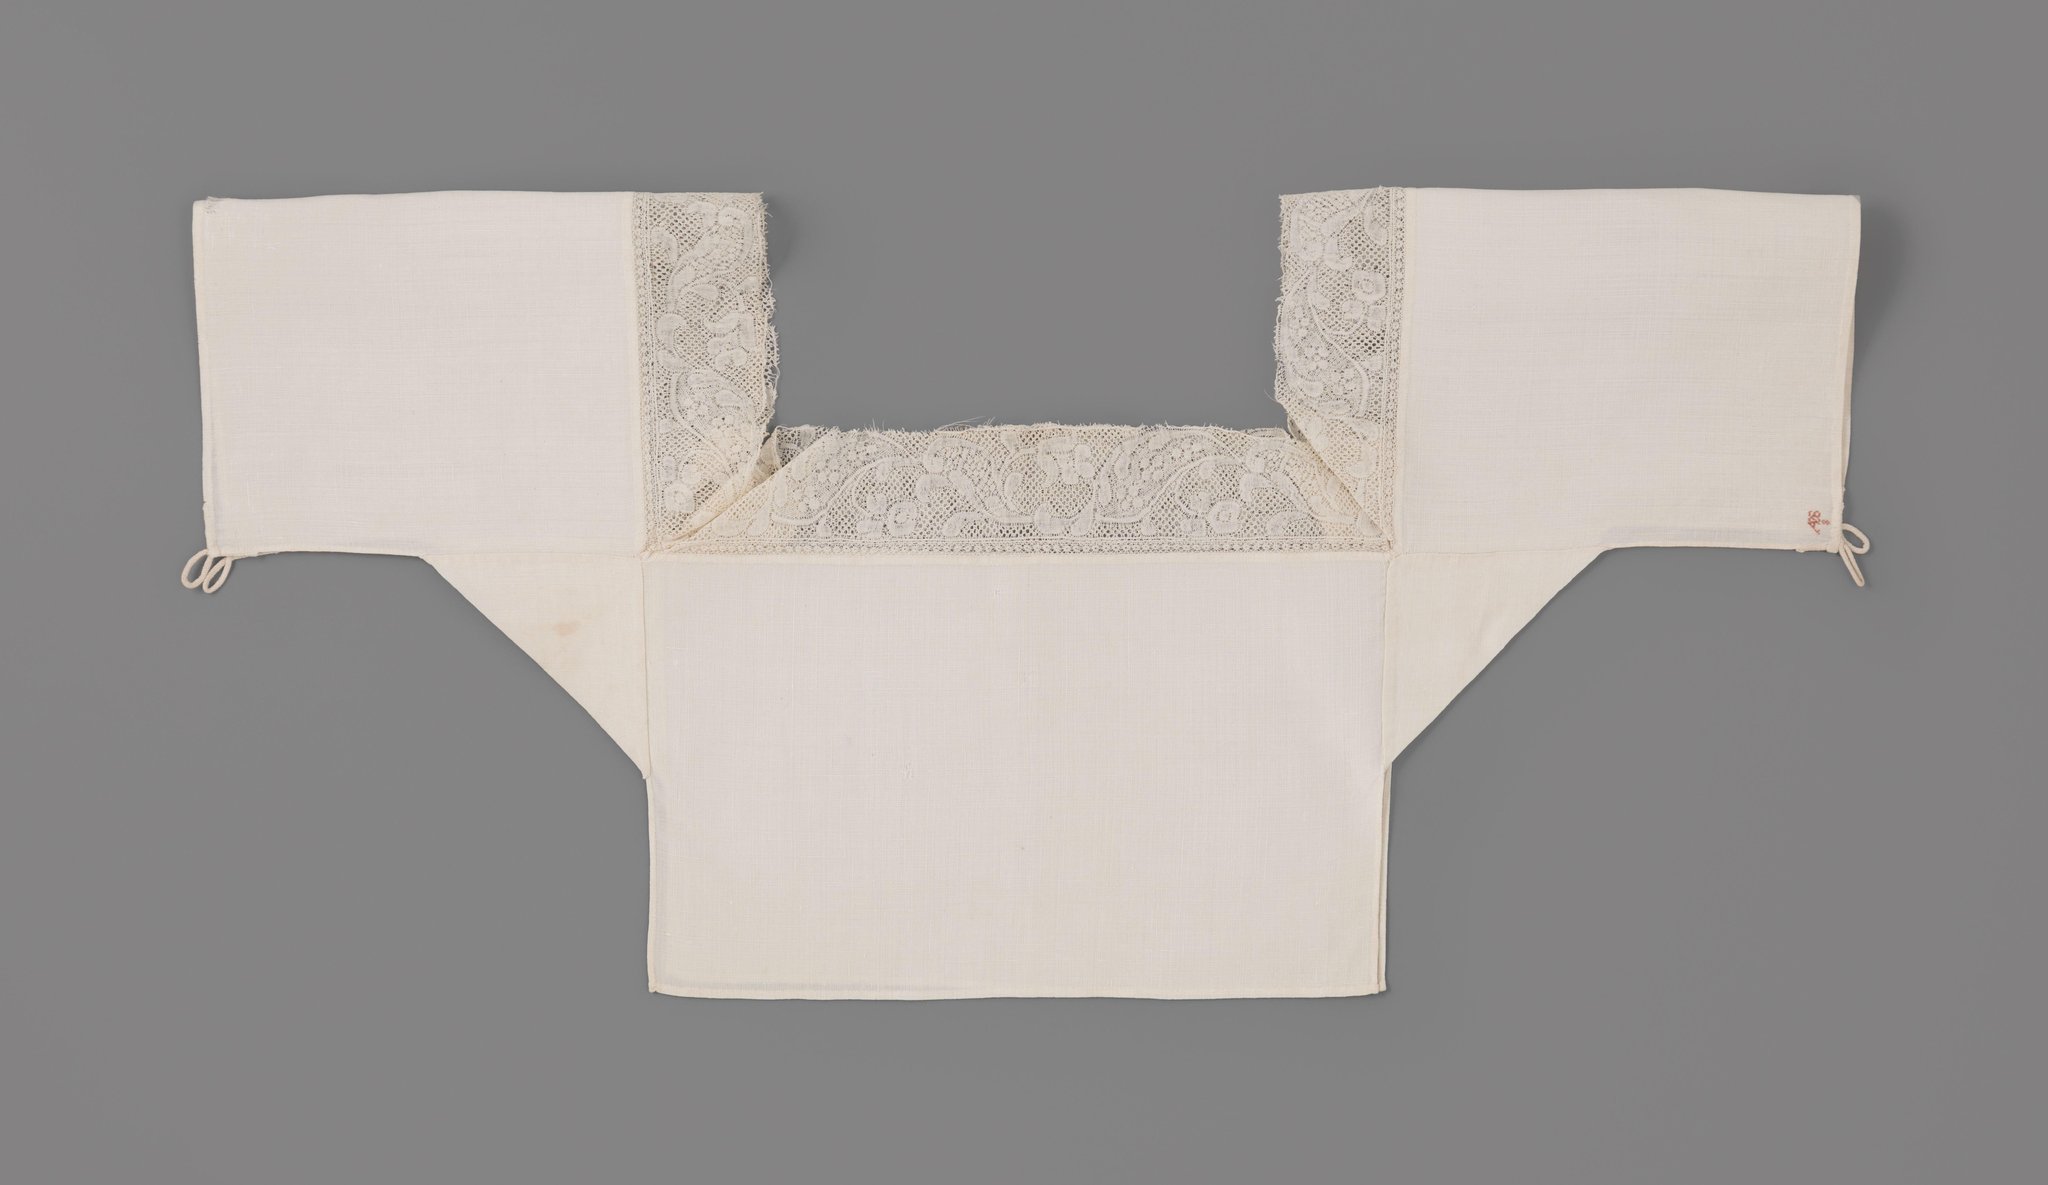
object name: chemise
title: Chemisette met strook Binchekant, versierd met lopende bloemrank met gelobd blad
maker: Anonymous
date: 1720-1730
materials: linen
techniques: lace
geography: southern netherlands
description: Chemisette met strook Binchekant, versierd met lopende bloemrank met gelobd blad. De rand is gepicoteerd.